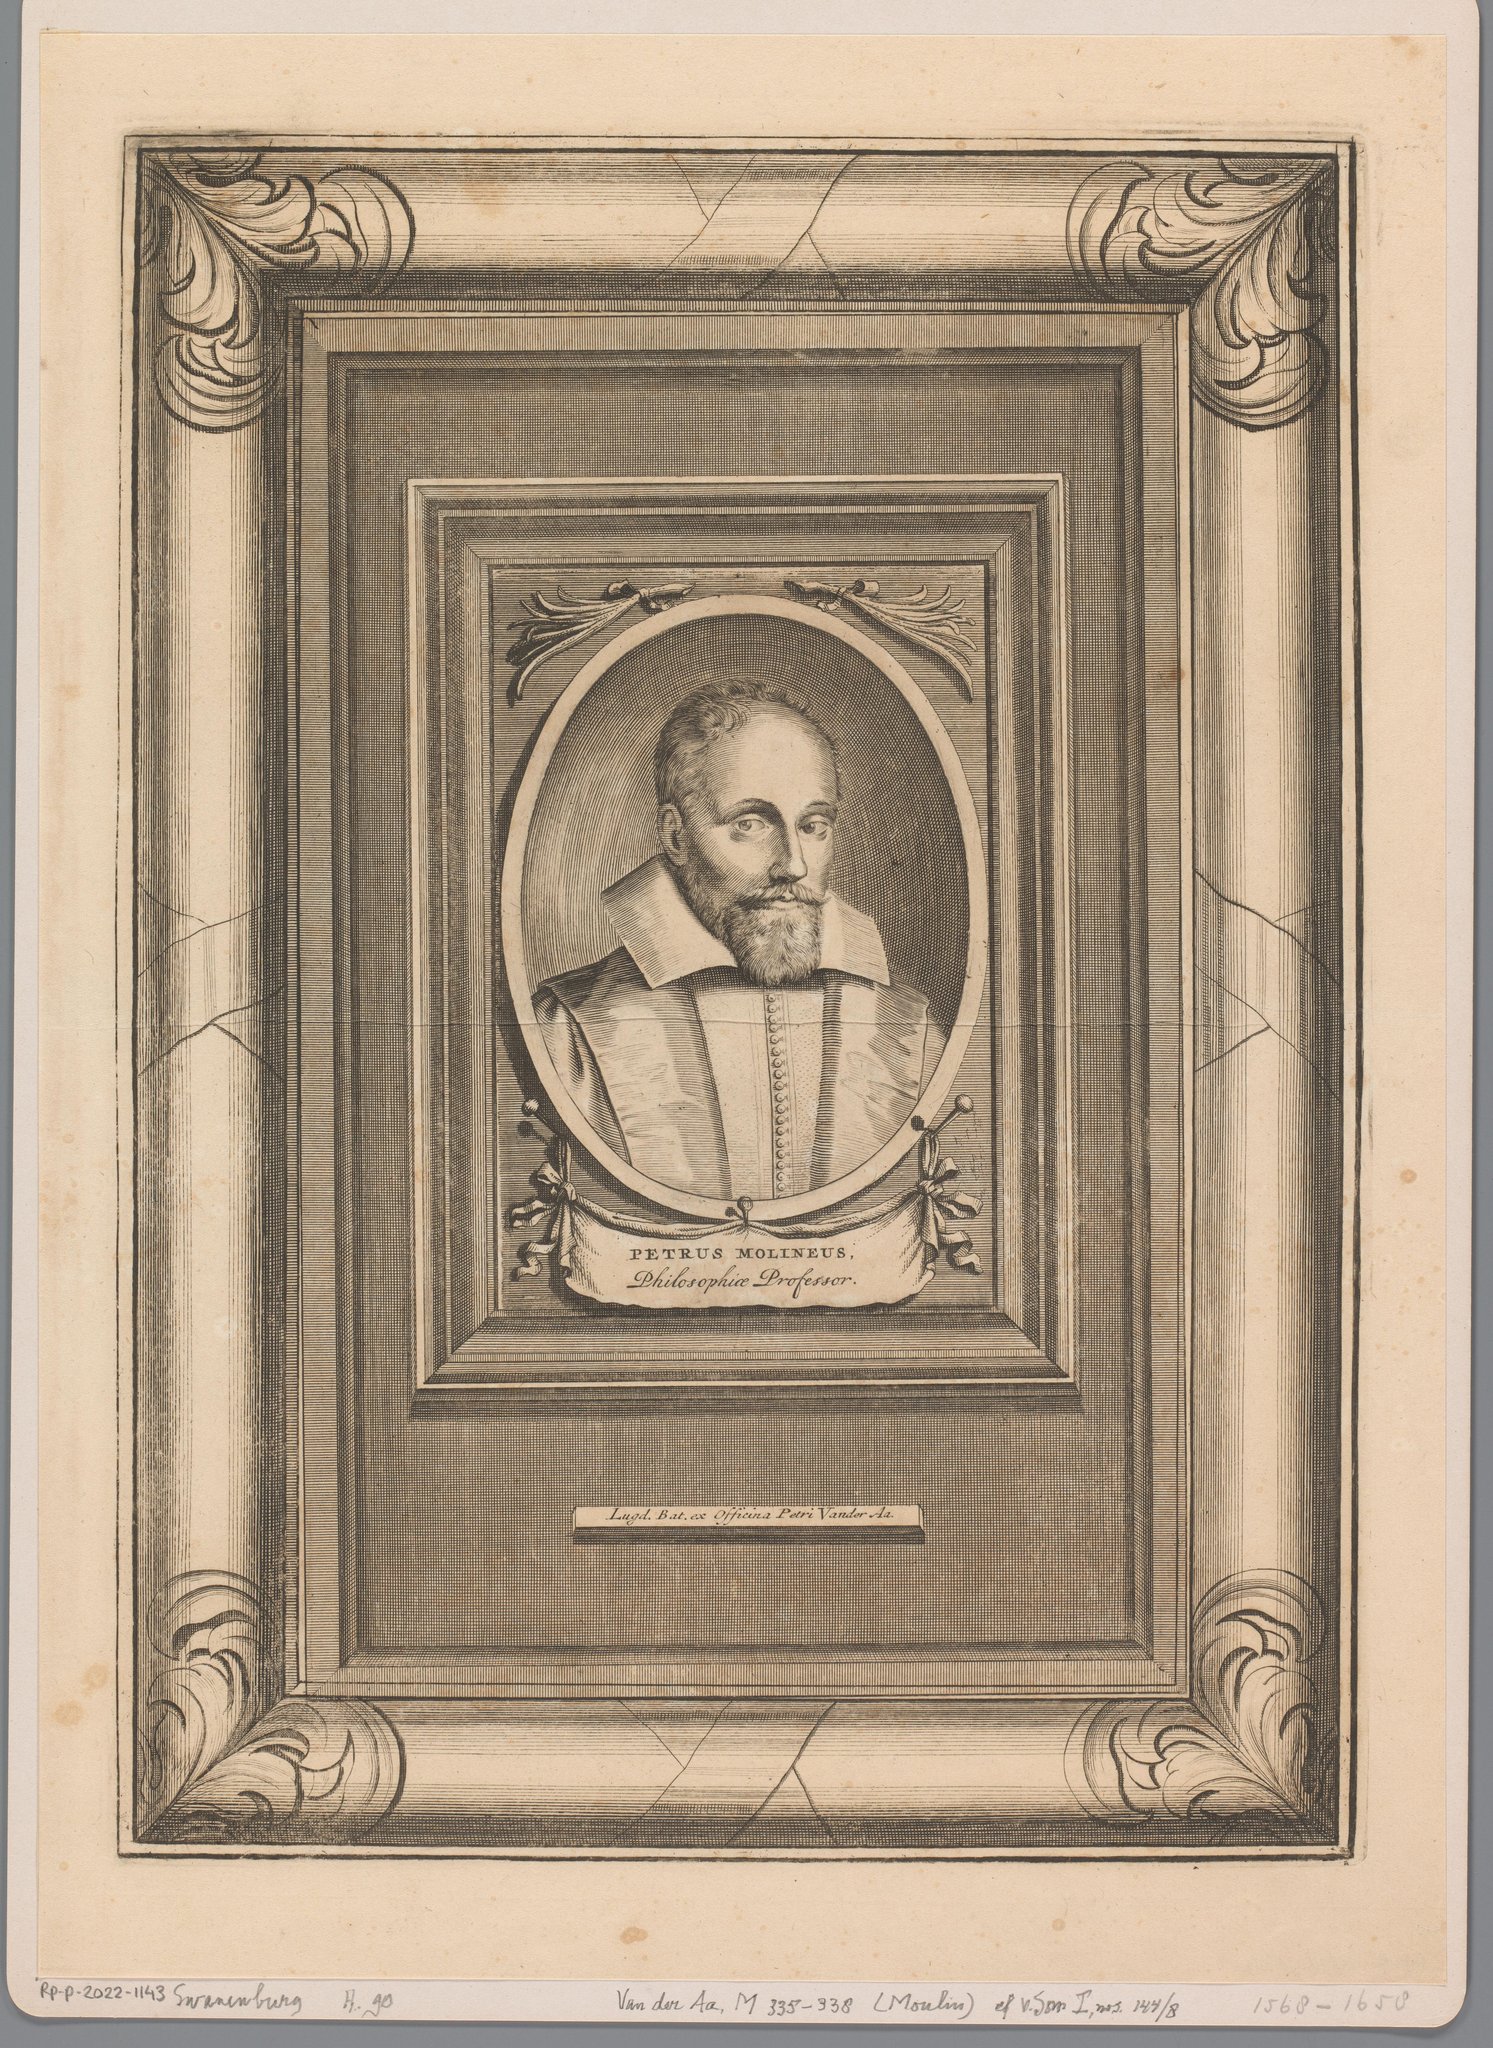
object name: print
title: Petrus Molineus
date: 1668-1733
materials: paper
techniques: engraving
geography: leiden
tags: minister ~ government, historical persons